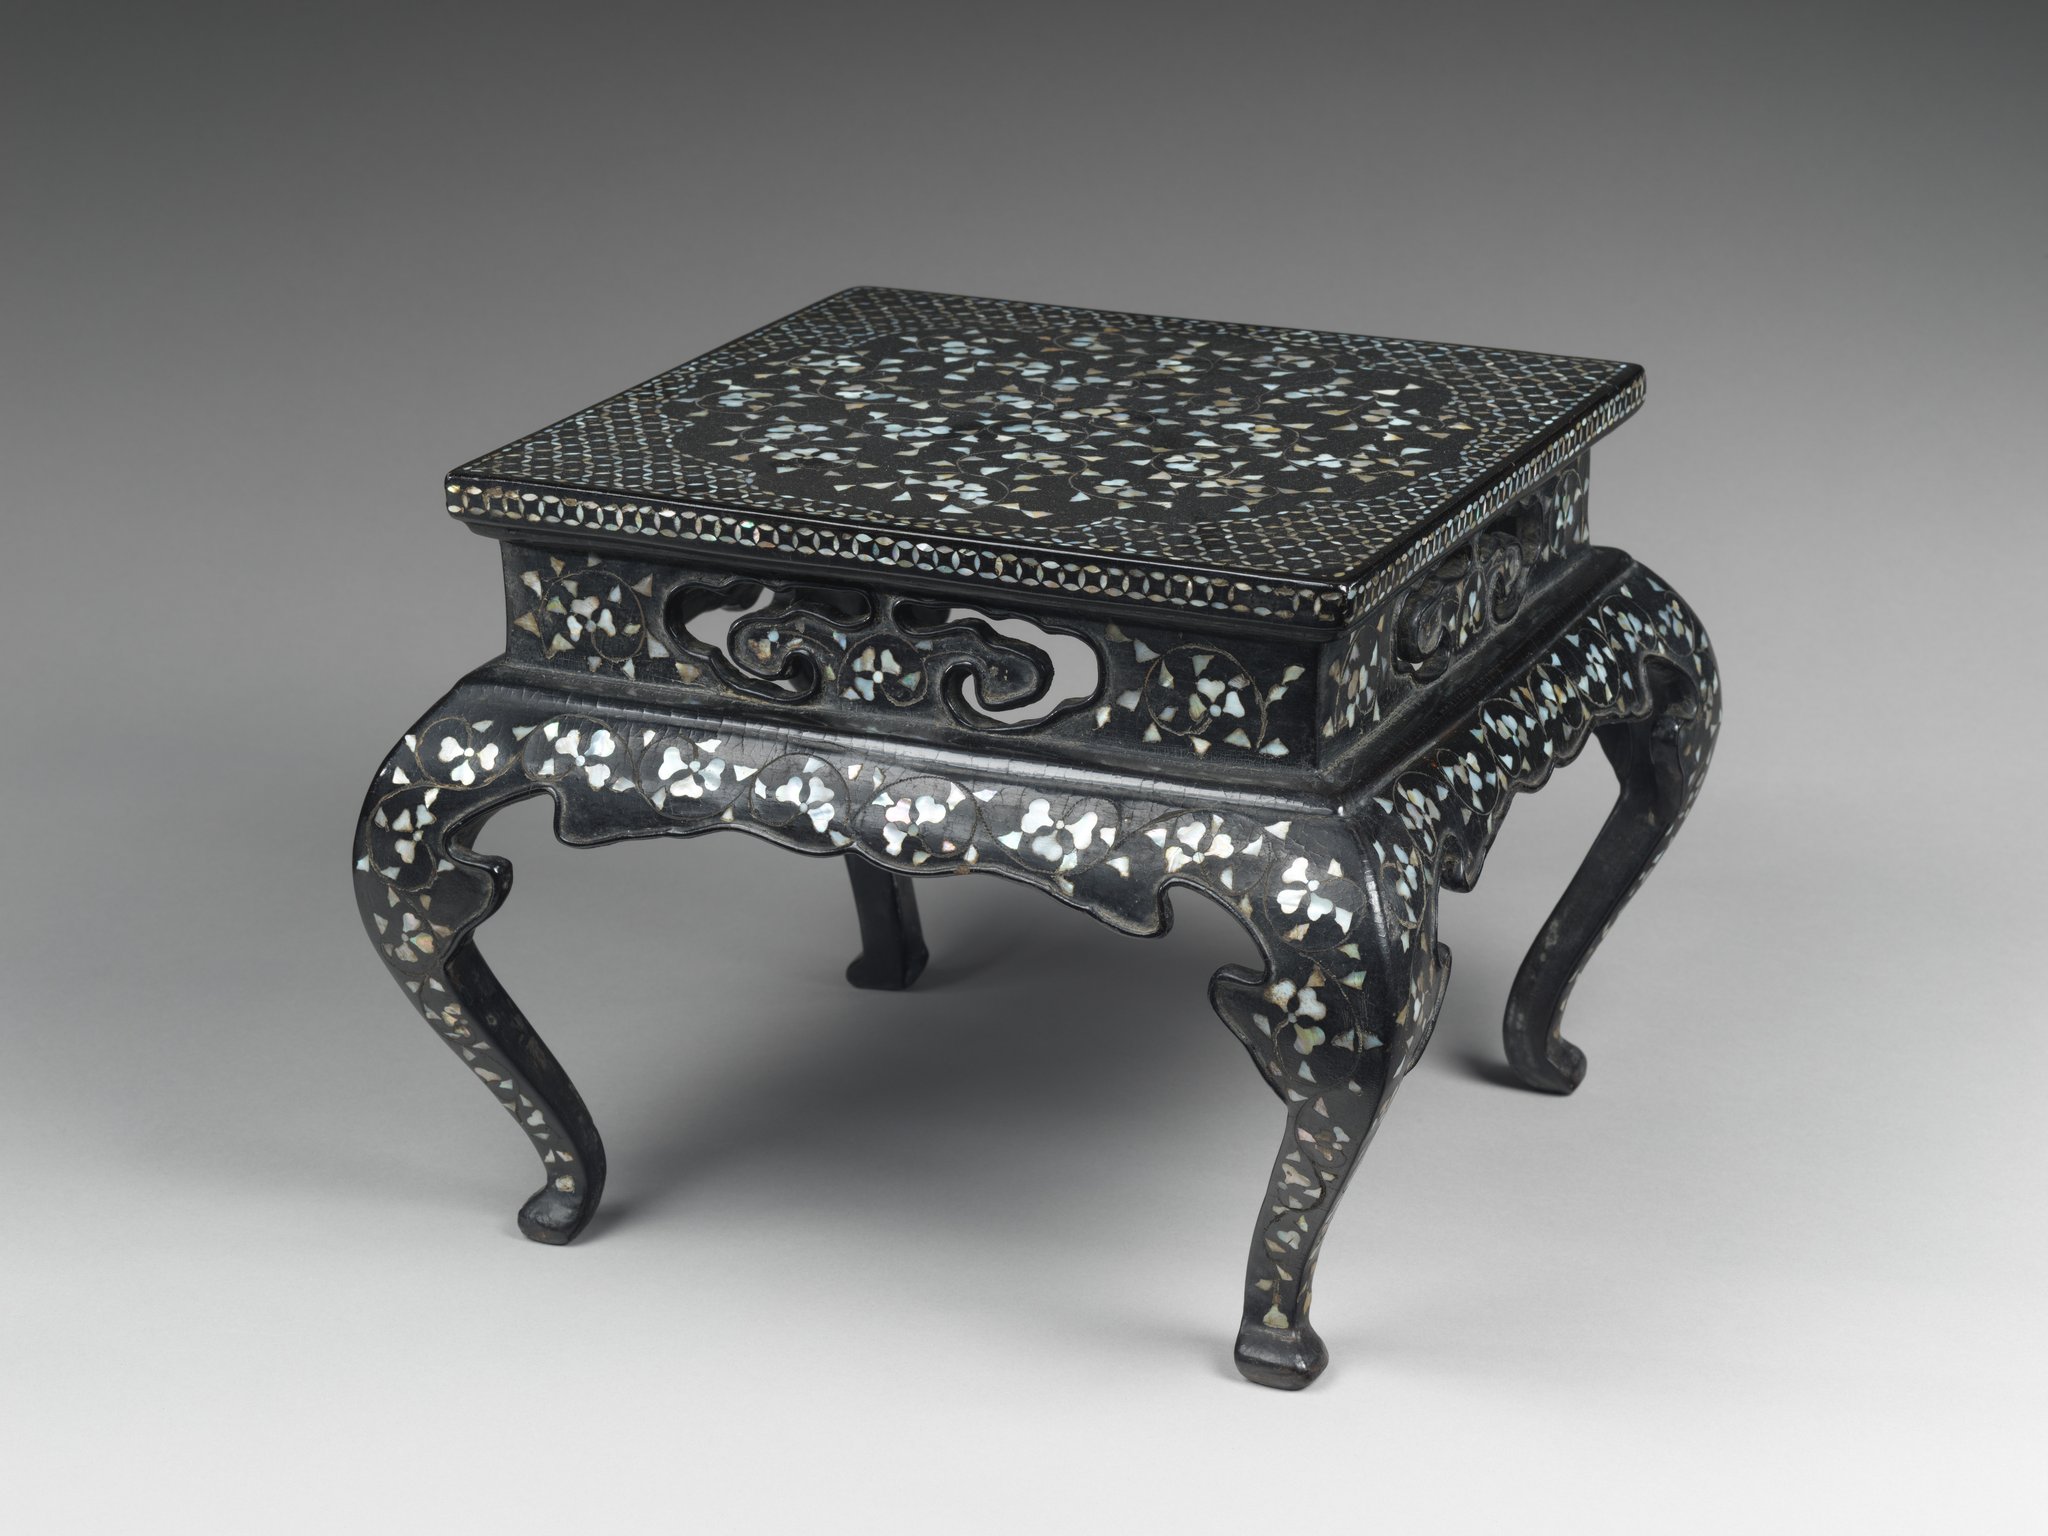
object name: table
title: Table decorated with floral scroll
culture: korean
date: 1801-1900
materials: lacquer, metal, mother of pearl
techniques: inlay